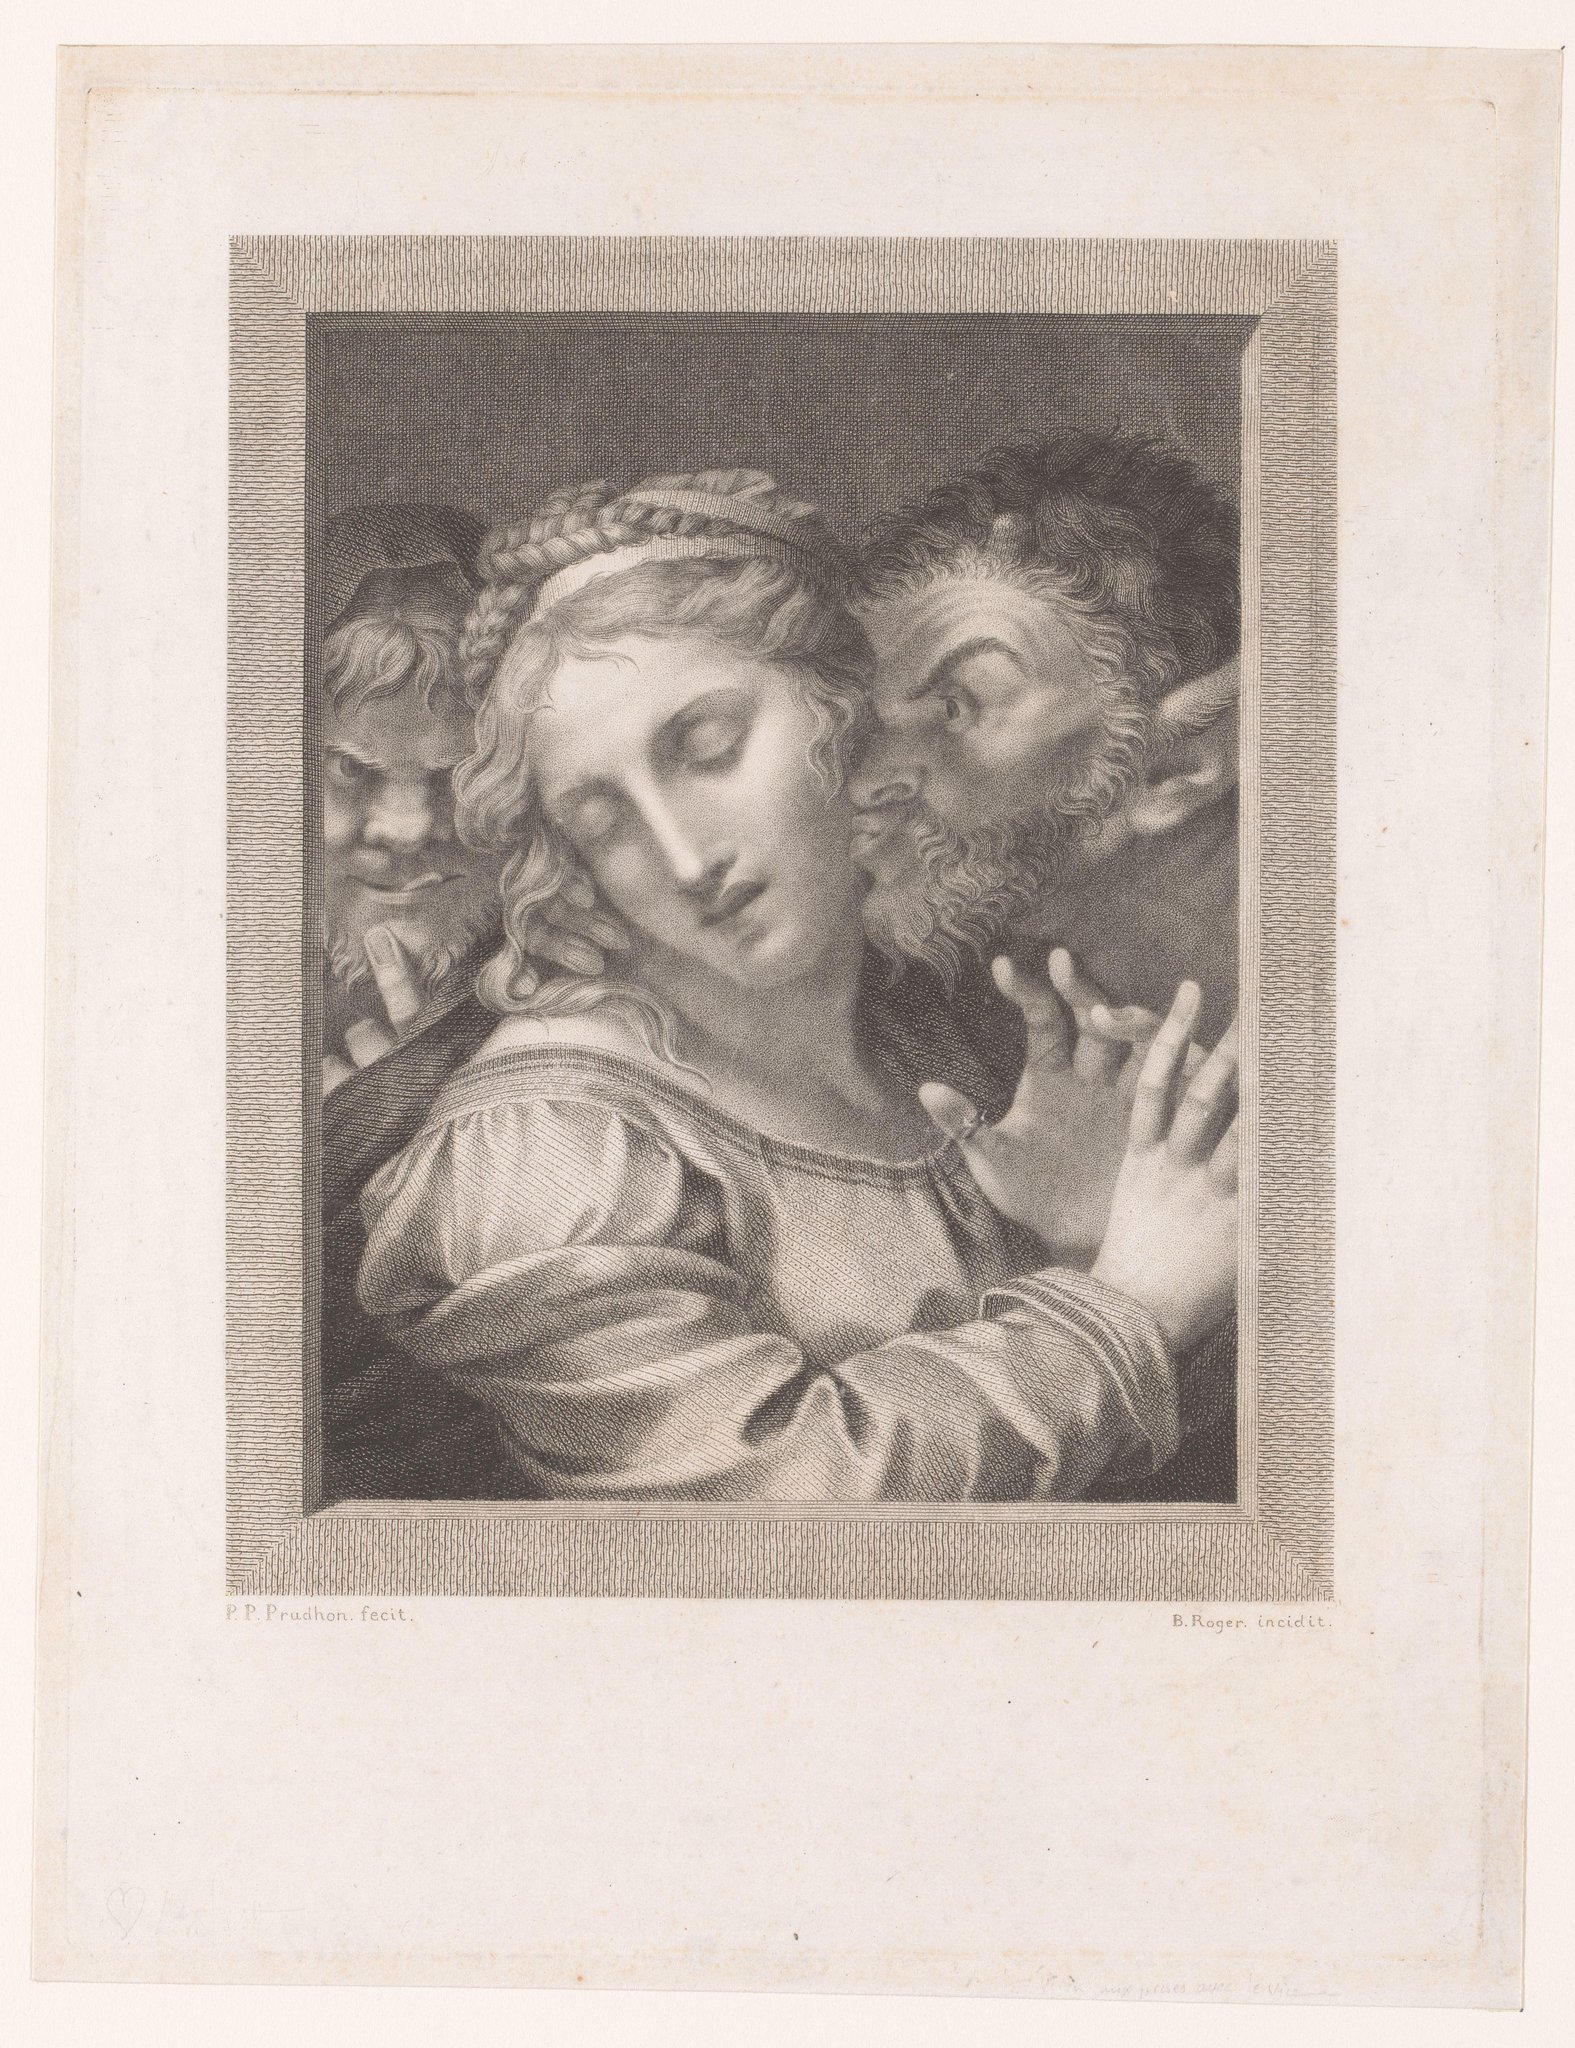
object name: print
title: La Vertu aux prises avec le vice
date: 1796-1799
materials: paper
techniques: engraving, etching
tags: figure representing a virtue vs. a vice, satyr(s) (in general)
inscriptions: collector's mark: Lugt 2228, collector's mark: Lugt 2760